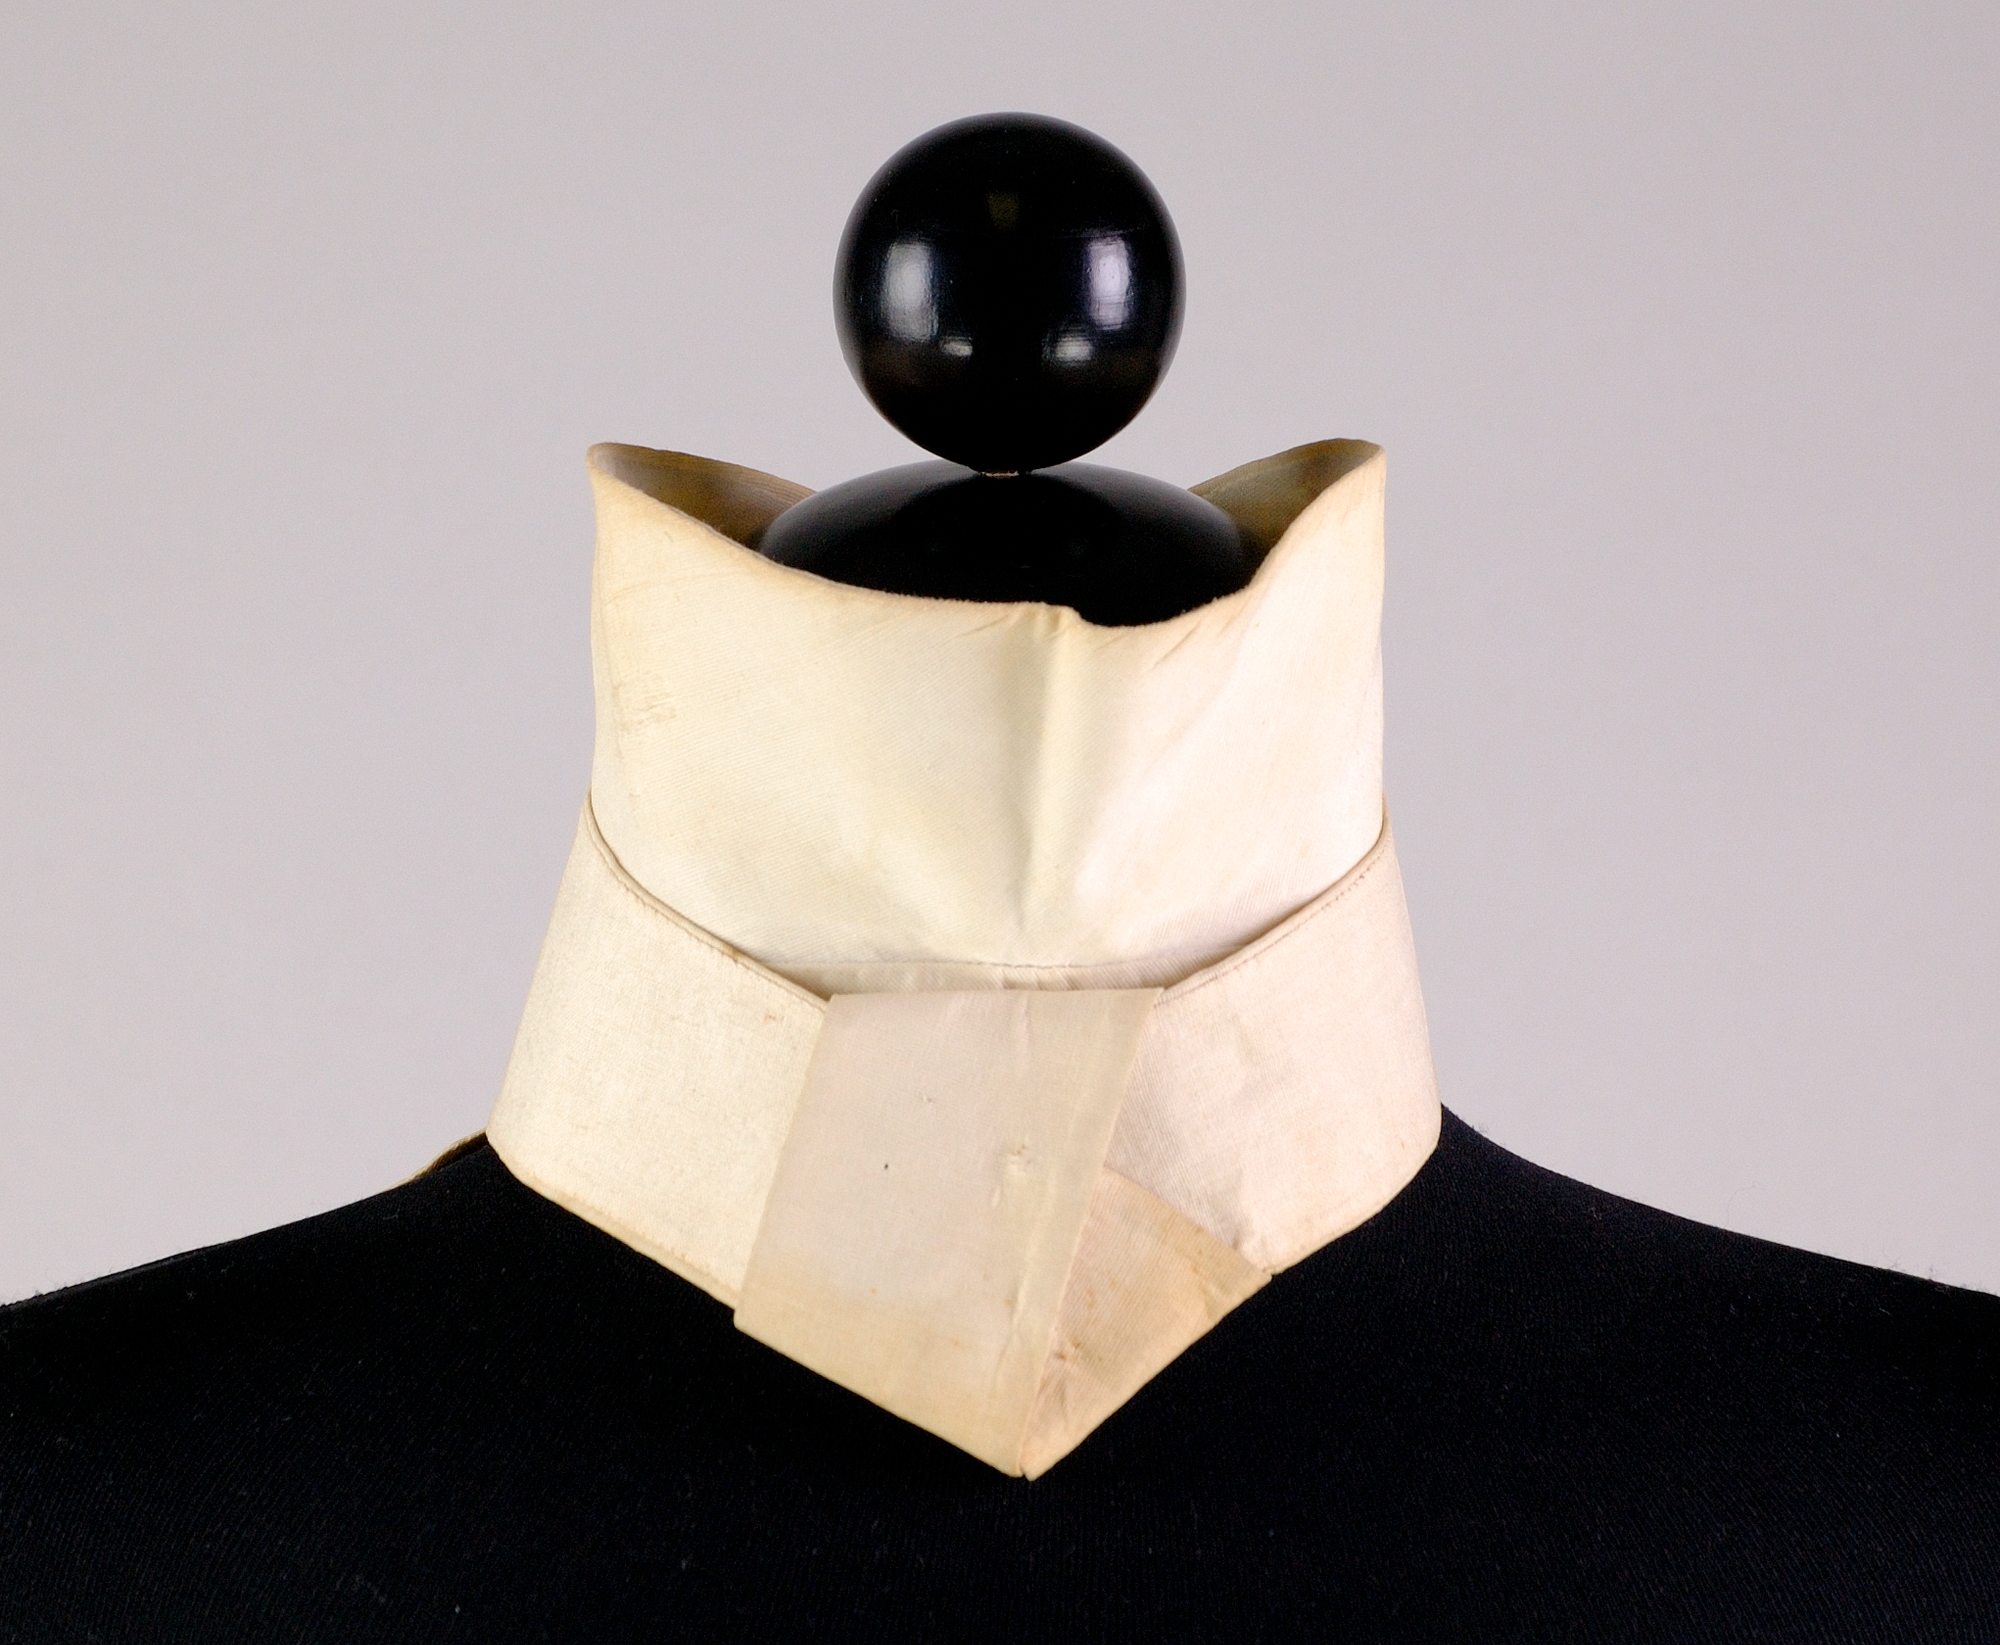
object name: stock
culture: american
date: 1834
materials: cotton